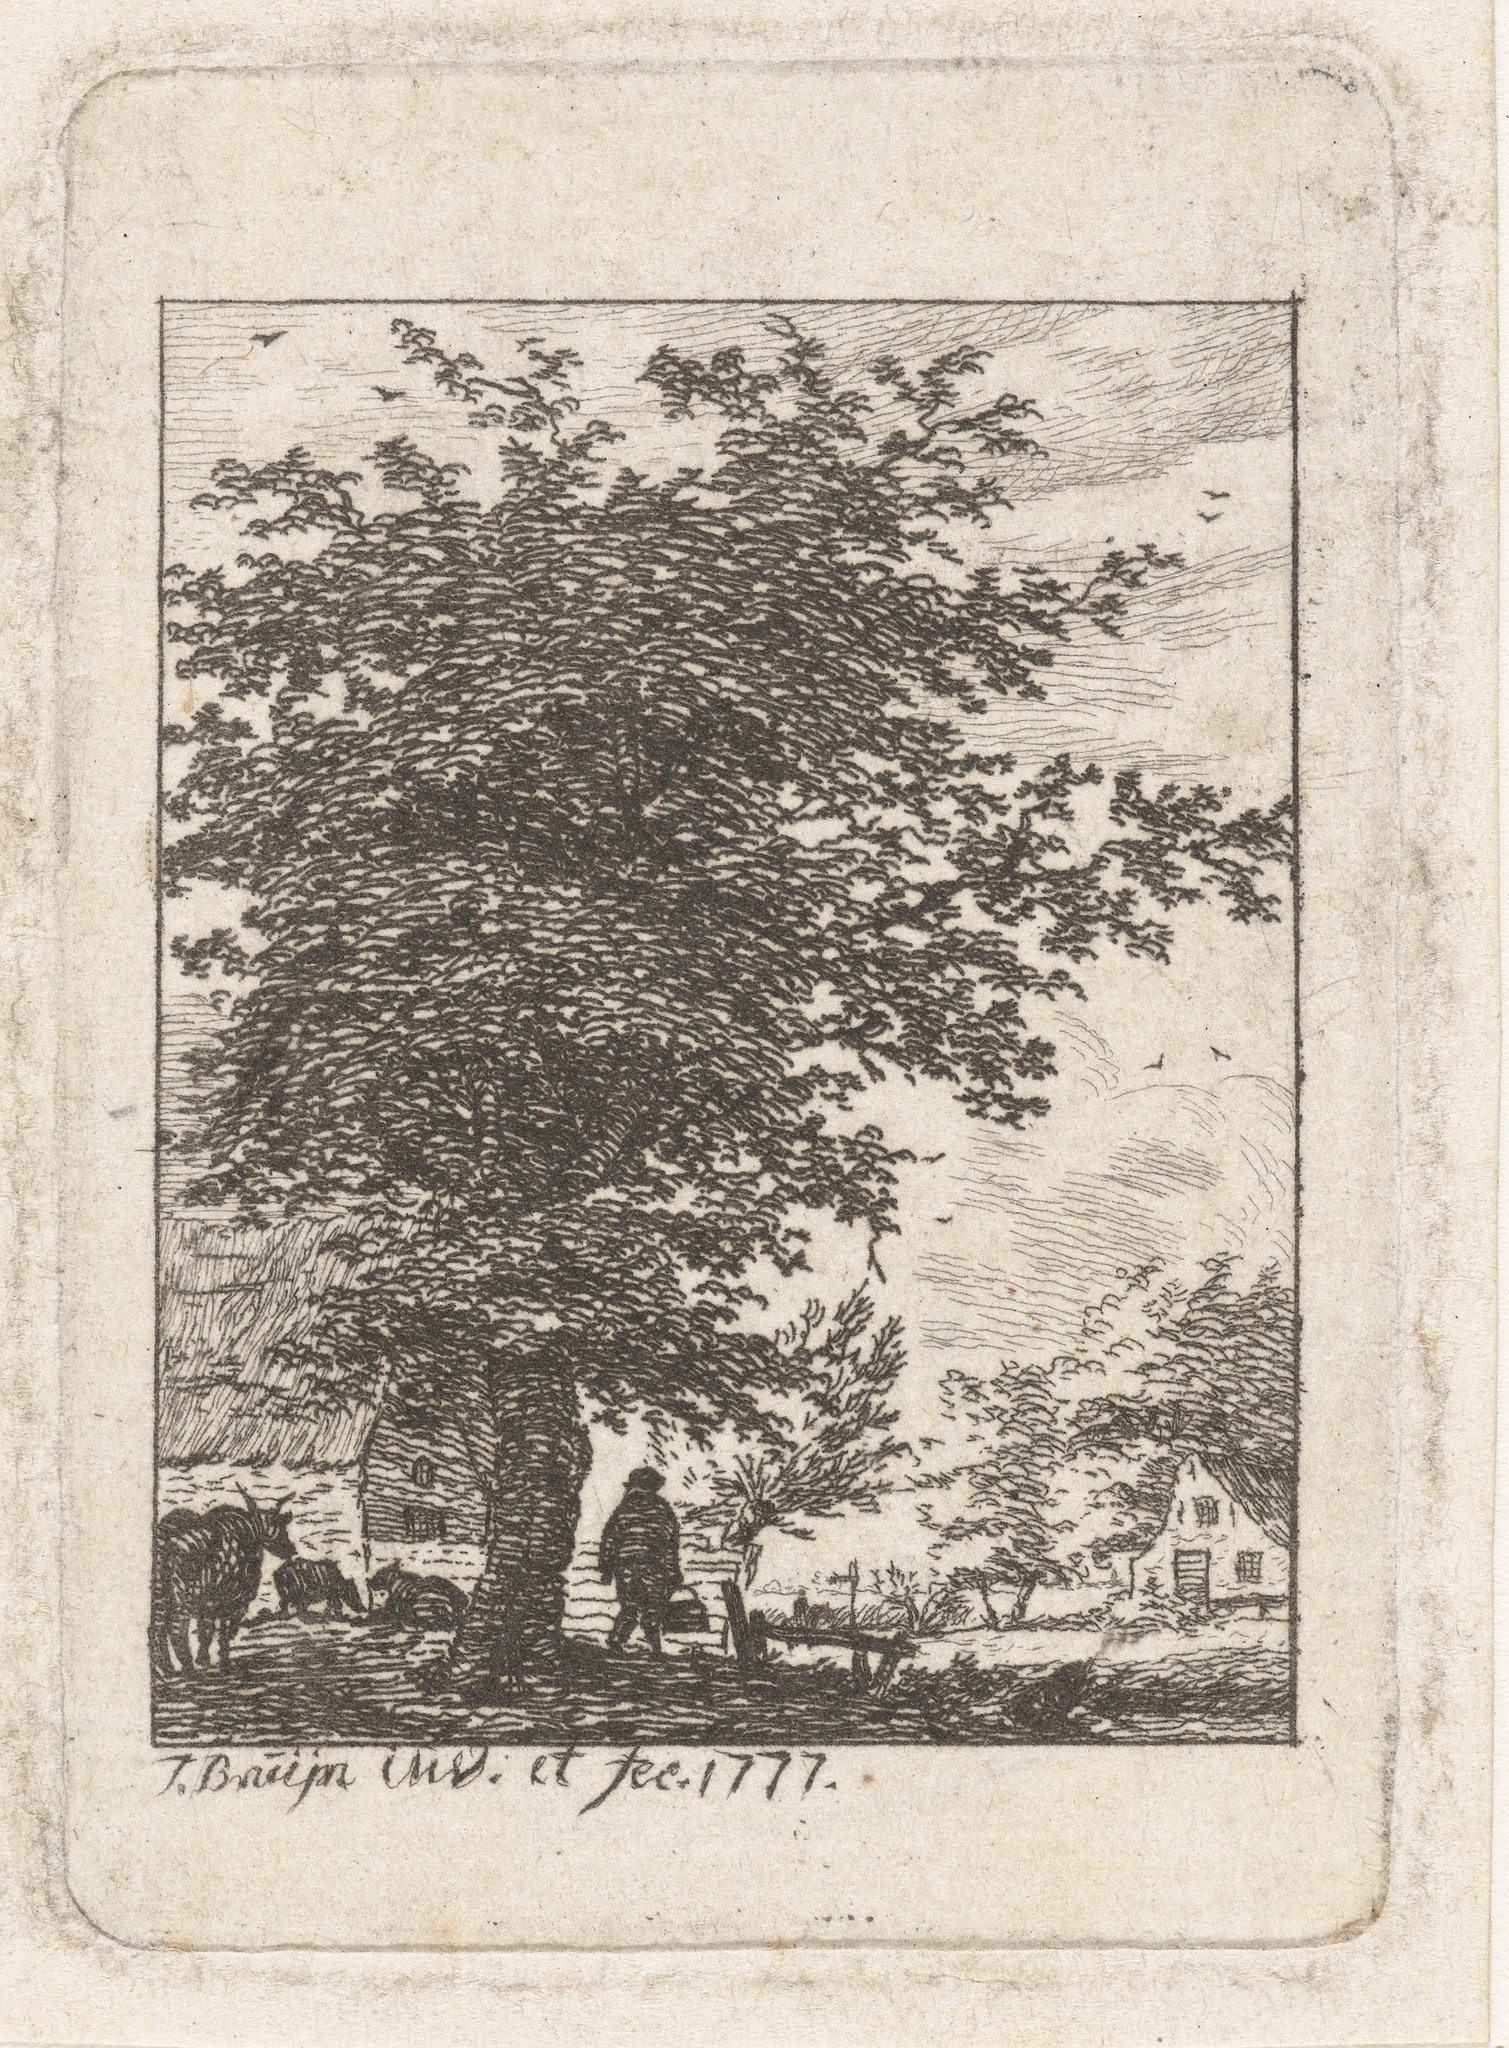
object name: print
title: Dorpsgezicht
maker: johanna de bruyn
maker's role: draughtsman, print maker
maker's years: 1722-1782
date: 1777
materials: paper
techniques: etching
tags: cow, outskirts of village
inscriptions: collector's mark: Lugt 2228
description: Een wei met enkele koeien en een grote boom op de voorgrond. Op de achtergrond enkele boerderijen. Een man wandelt richting een van de hoeves.